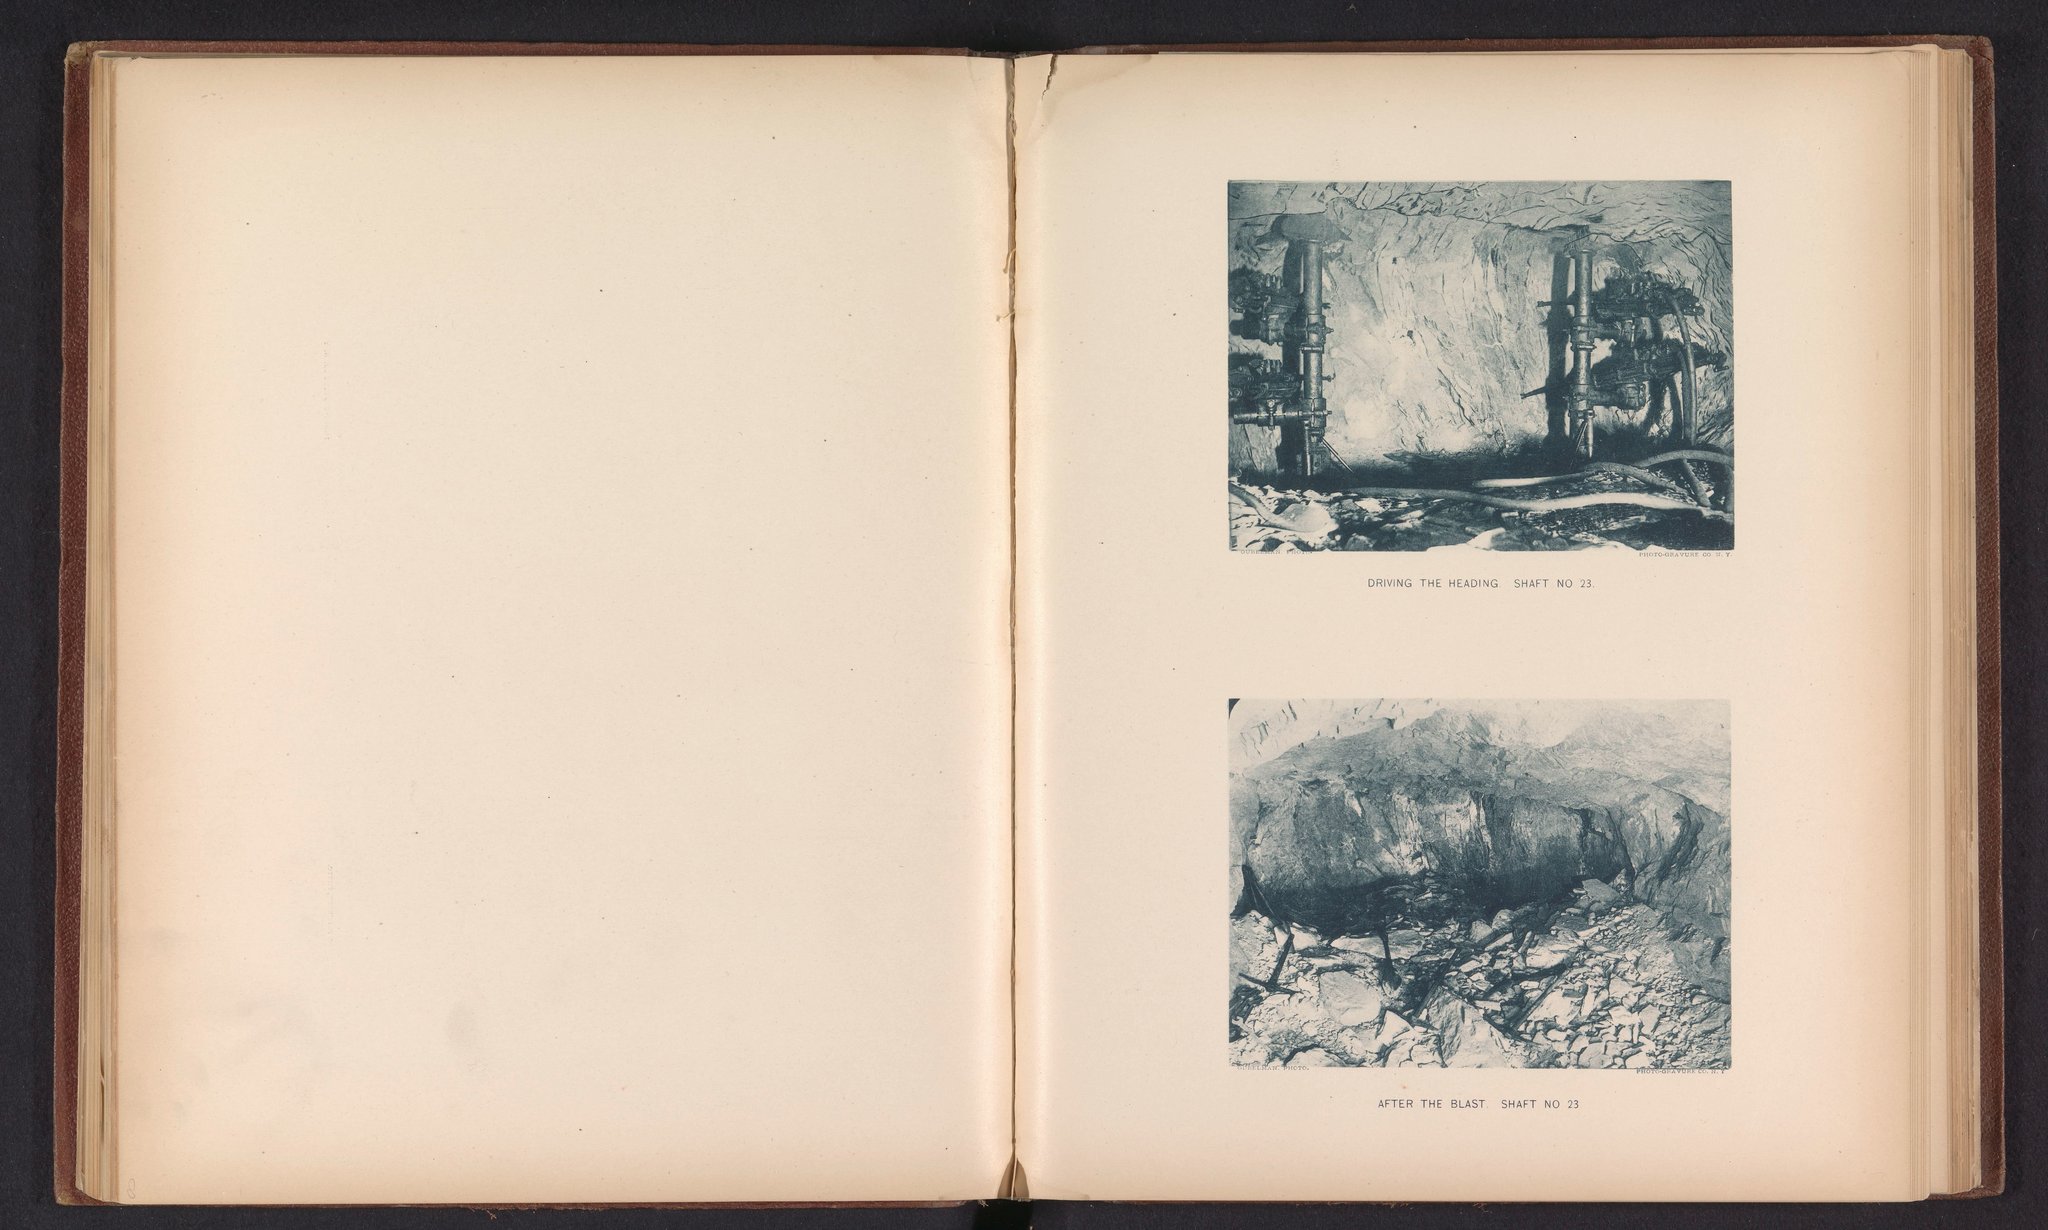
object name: photomechanical print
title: Driving the heading shaft no 23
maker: preston k. yates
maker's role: engineer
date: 1883-1887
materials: paper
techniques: photograph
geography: new york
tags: underground road, tunnel